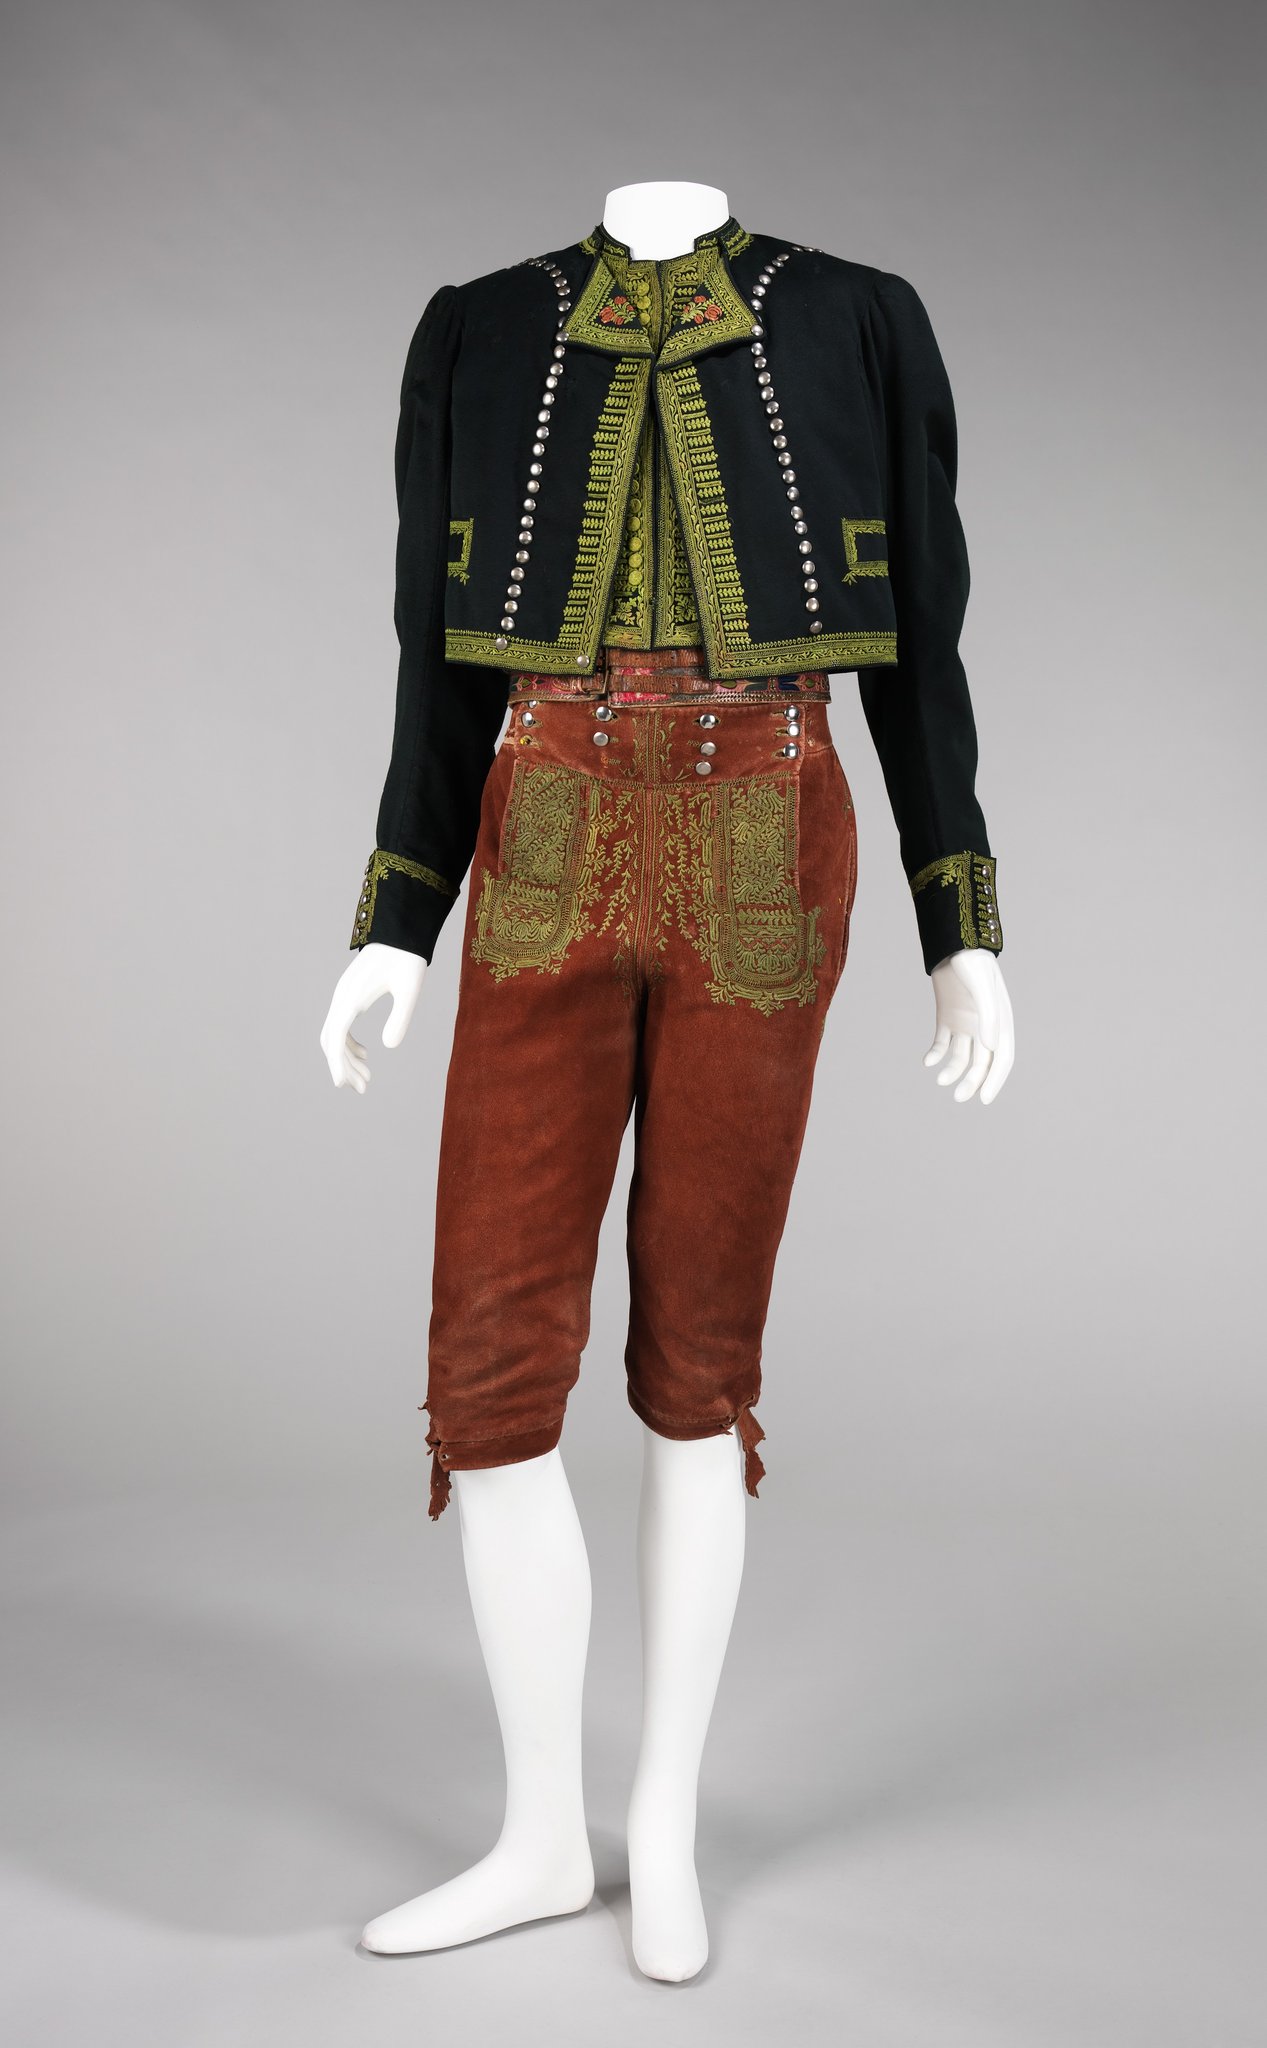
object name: ensemble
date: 1867-1900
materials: leather, metal, silk, wool